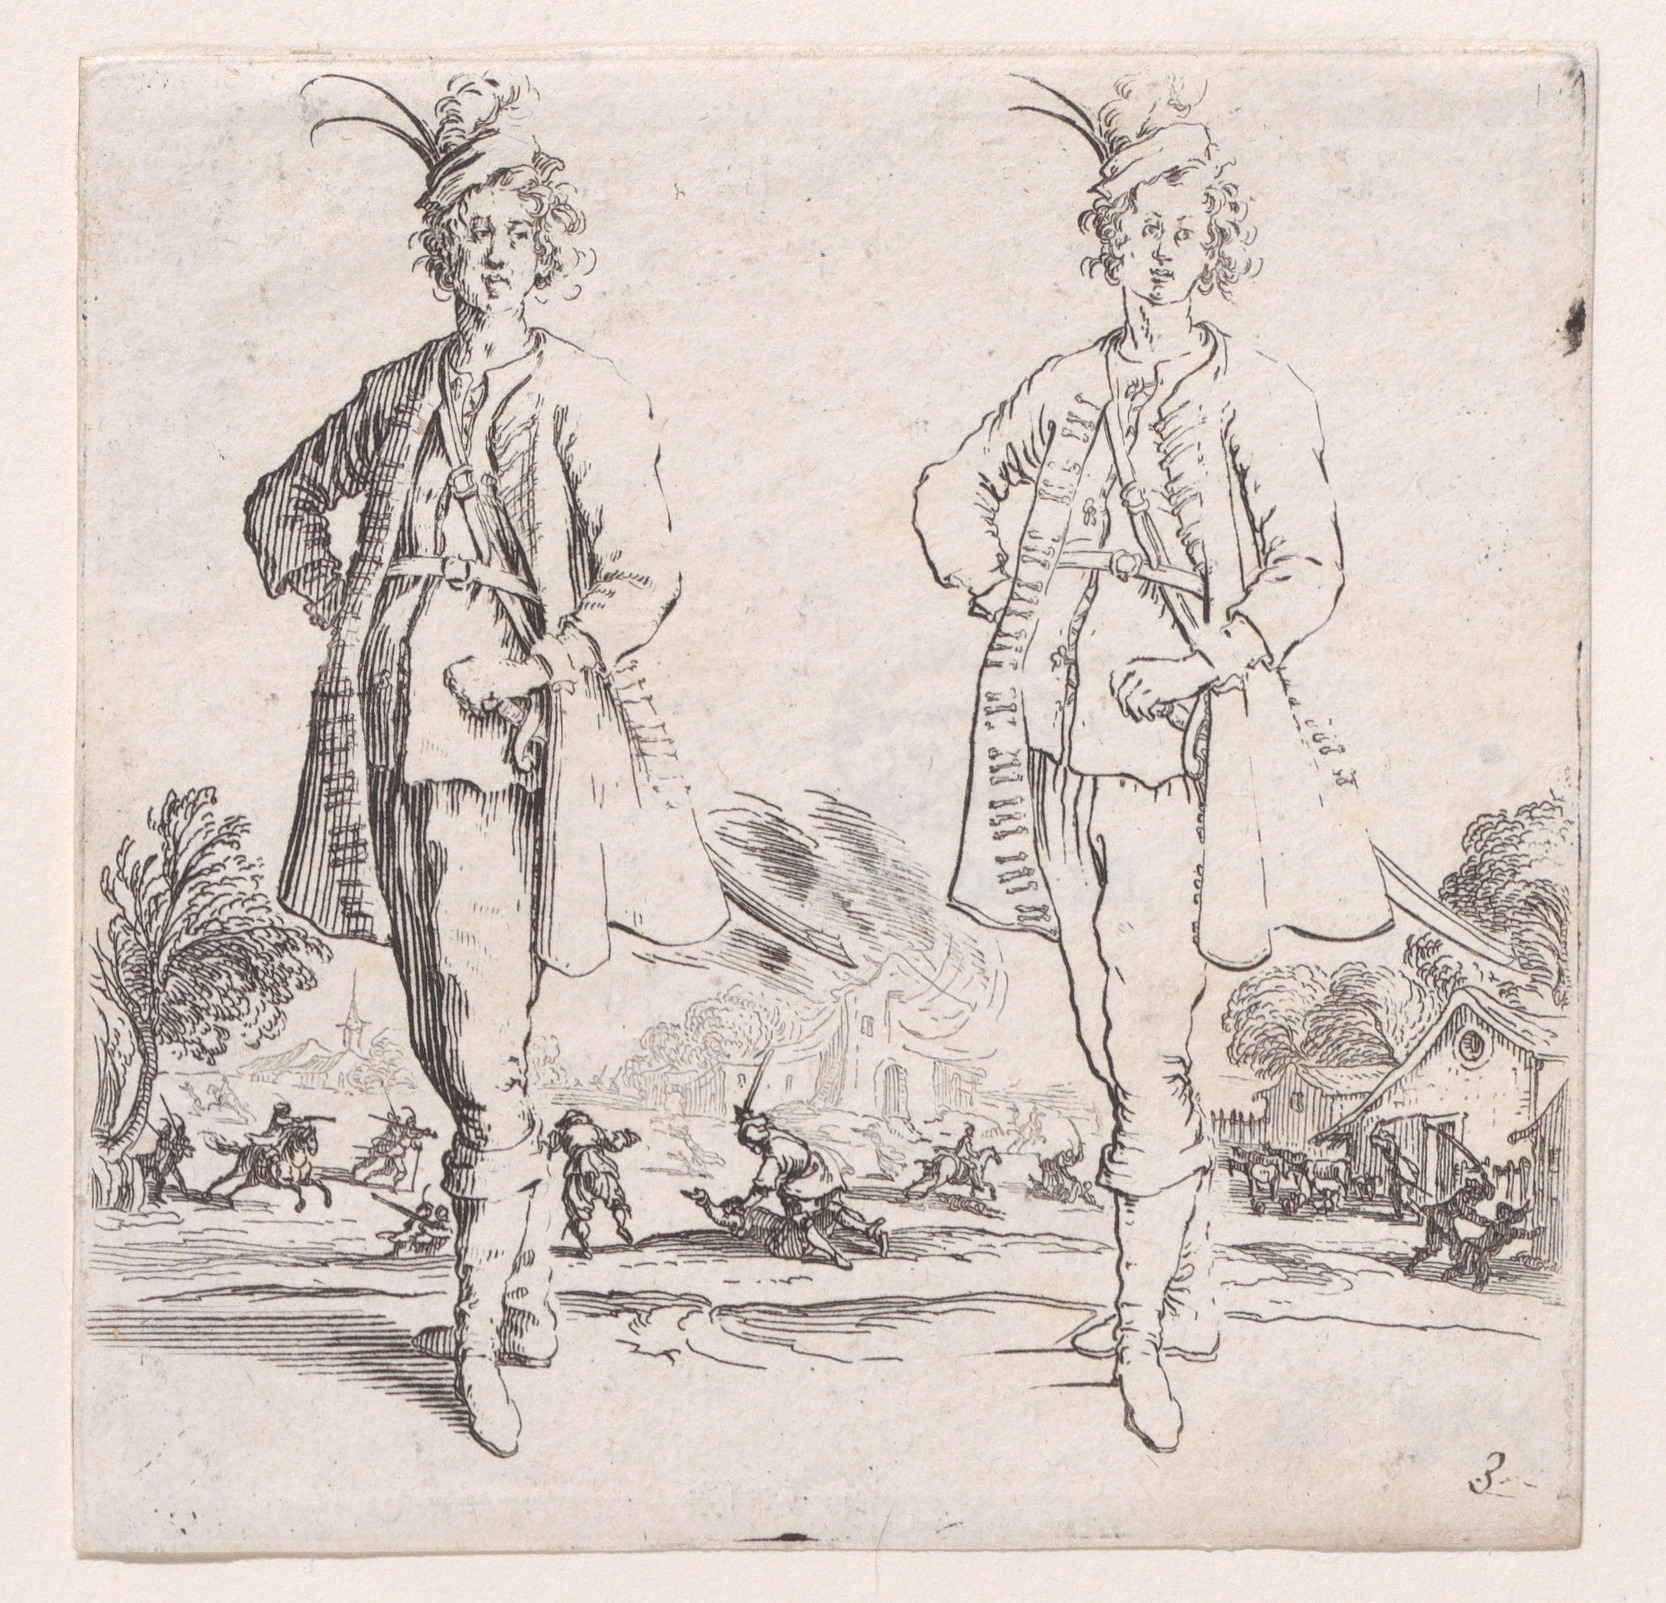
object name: print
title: Le Turc Vu de Face, La Main Droite Posée sur la Hanche (Front View of the Turk, Right Hand Placed on Hip), plate 3 from "Varie Figure" (Various Figures)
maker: jacques callot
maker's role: artist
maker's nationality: french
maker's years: 1592-1635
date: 1620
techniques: etching